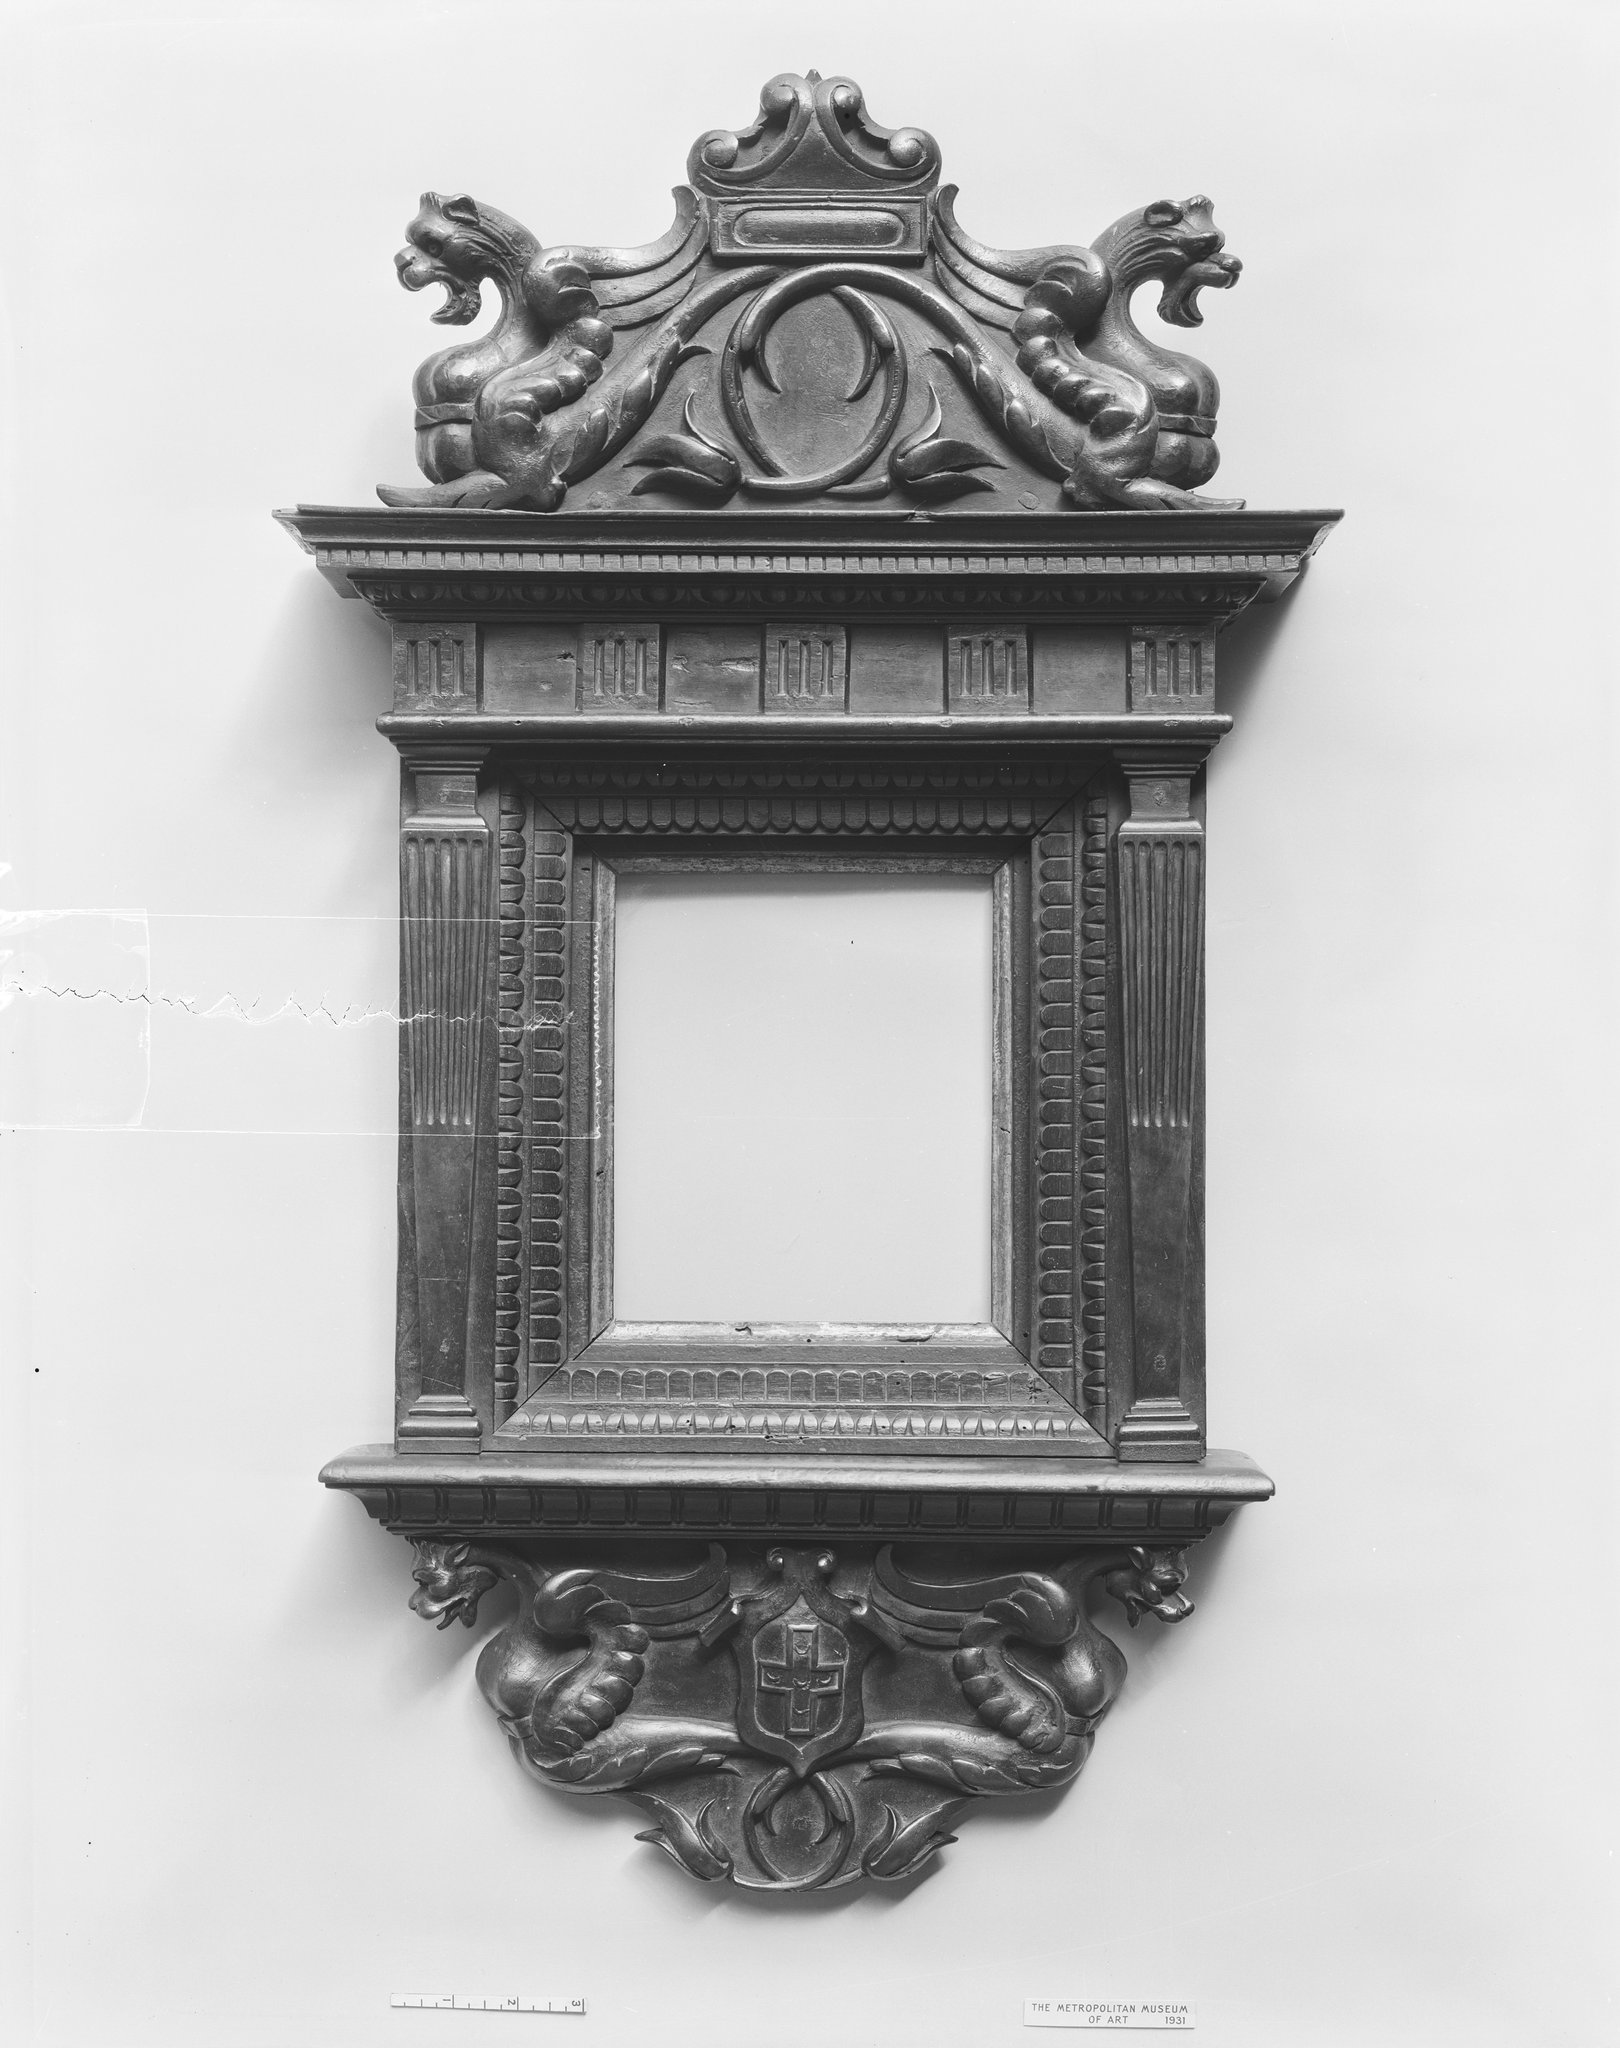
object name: mirror frame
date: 1501-1600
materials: wood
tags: dragons,coat of arms